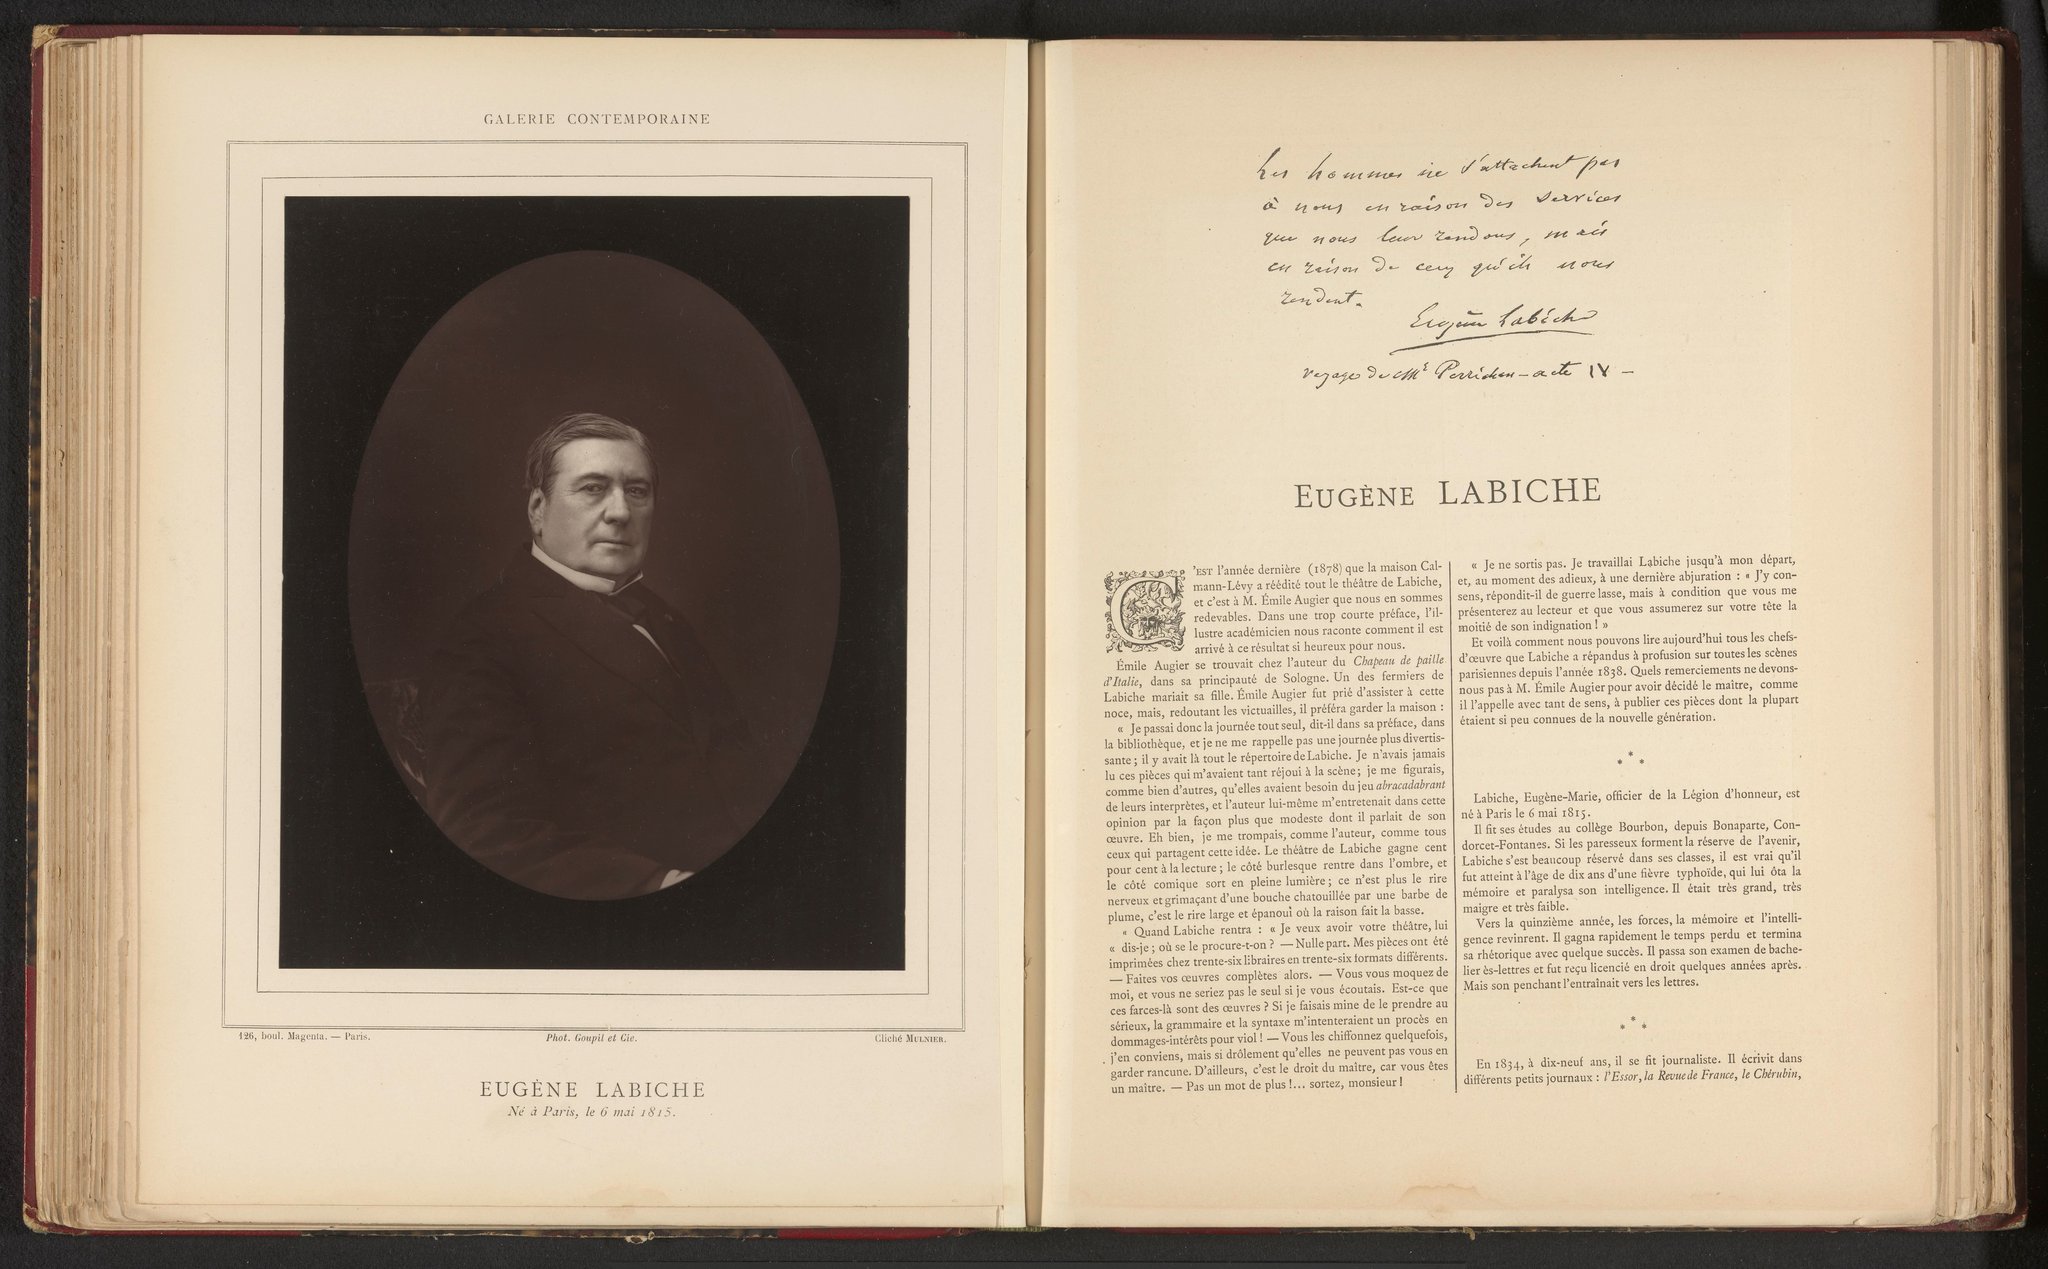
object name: photomechanical print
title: Portret van Eugène Labiche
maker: ferdinand mulnier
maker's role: painter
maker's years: 1817-1891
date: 1876-1879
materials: paper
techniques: woodburytype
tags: portrait of a writer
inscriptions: inscription: ‘126, boul. Magenta.-Paris.’